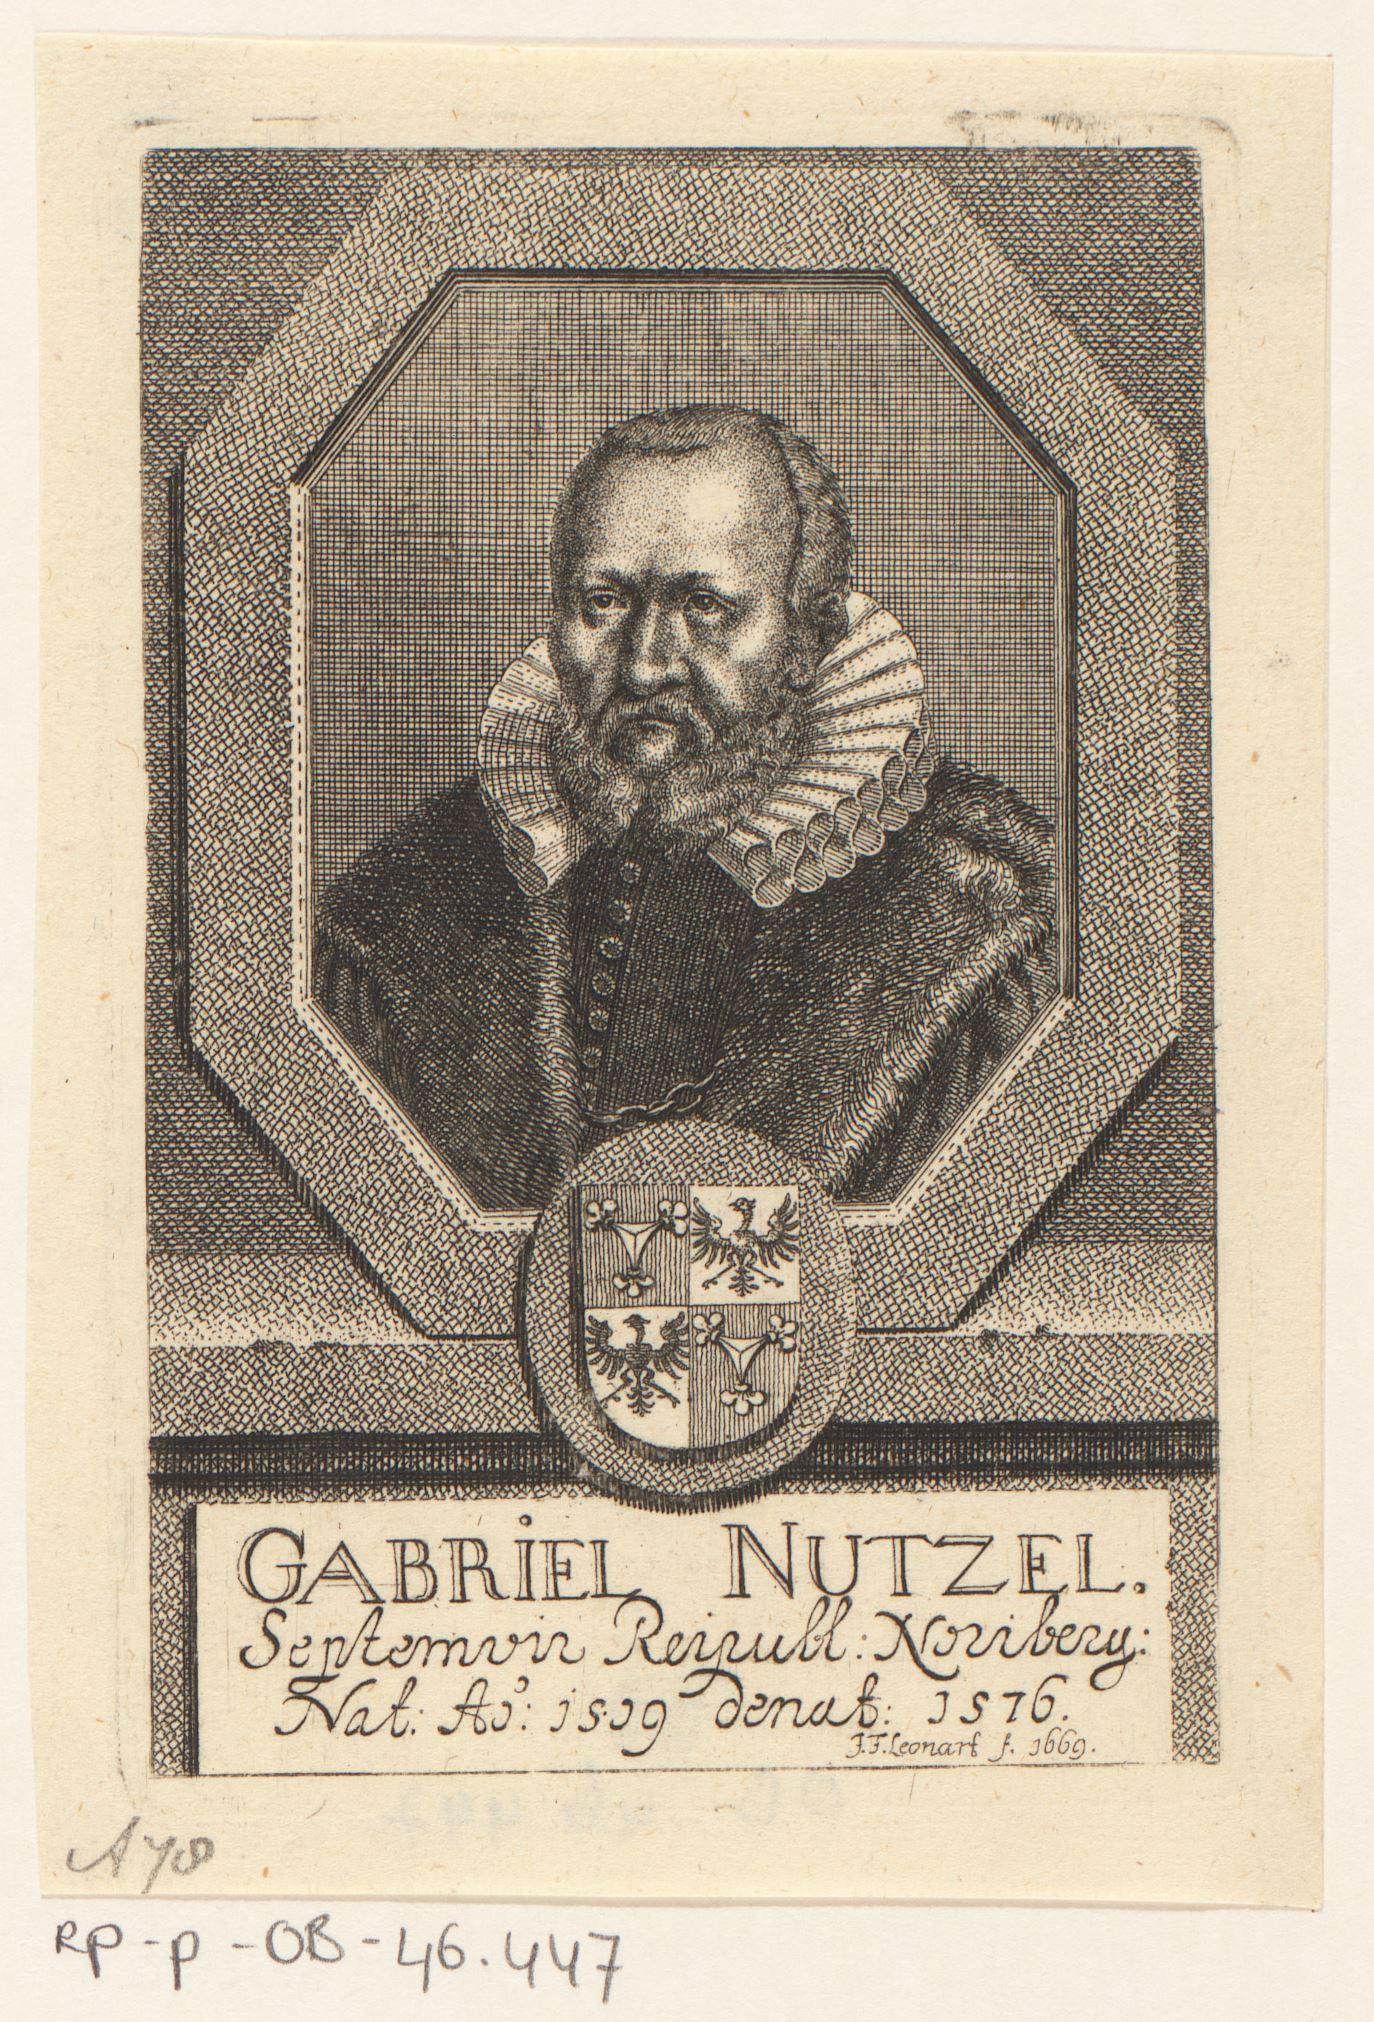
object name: print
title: Portret van Gabriel Nützel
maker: johann friedrich leonard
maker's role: print maker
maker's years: 1633-1680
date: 1669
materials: paper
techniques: engraving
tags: diplomaat, raadsheer, gabriel nützel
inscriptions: collector's mark: Lugt 2228, collector's mark: Lugt 1337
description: Portret van Gabriel Nützel, raadsheer te Neurenberg, met familiewapen.